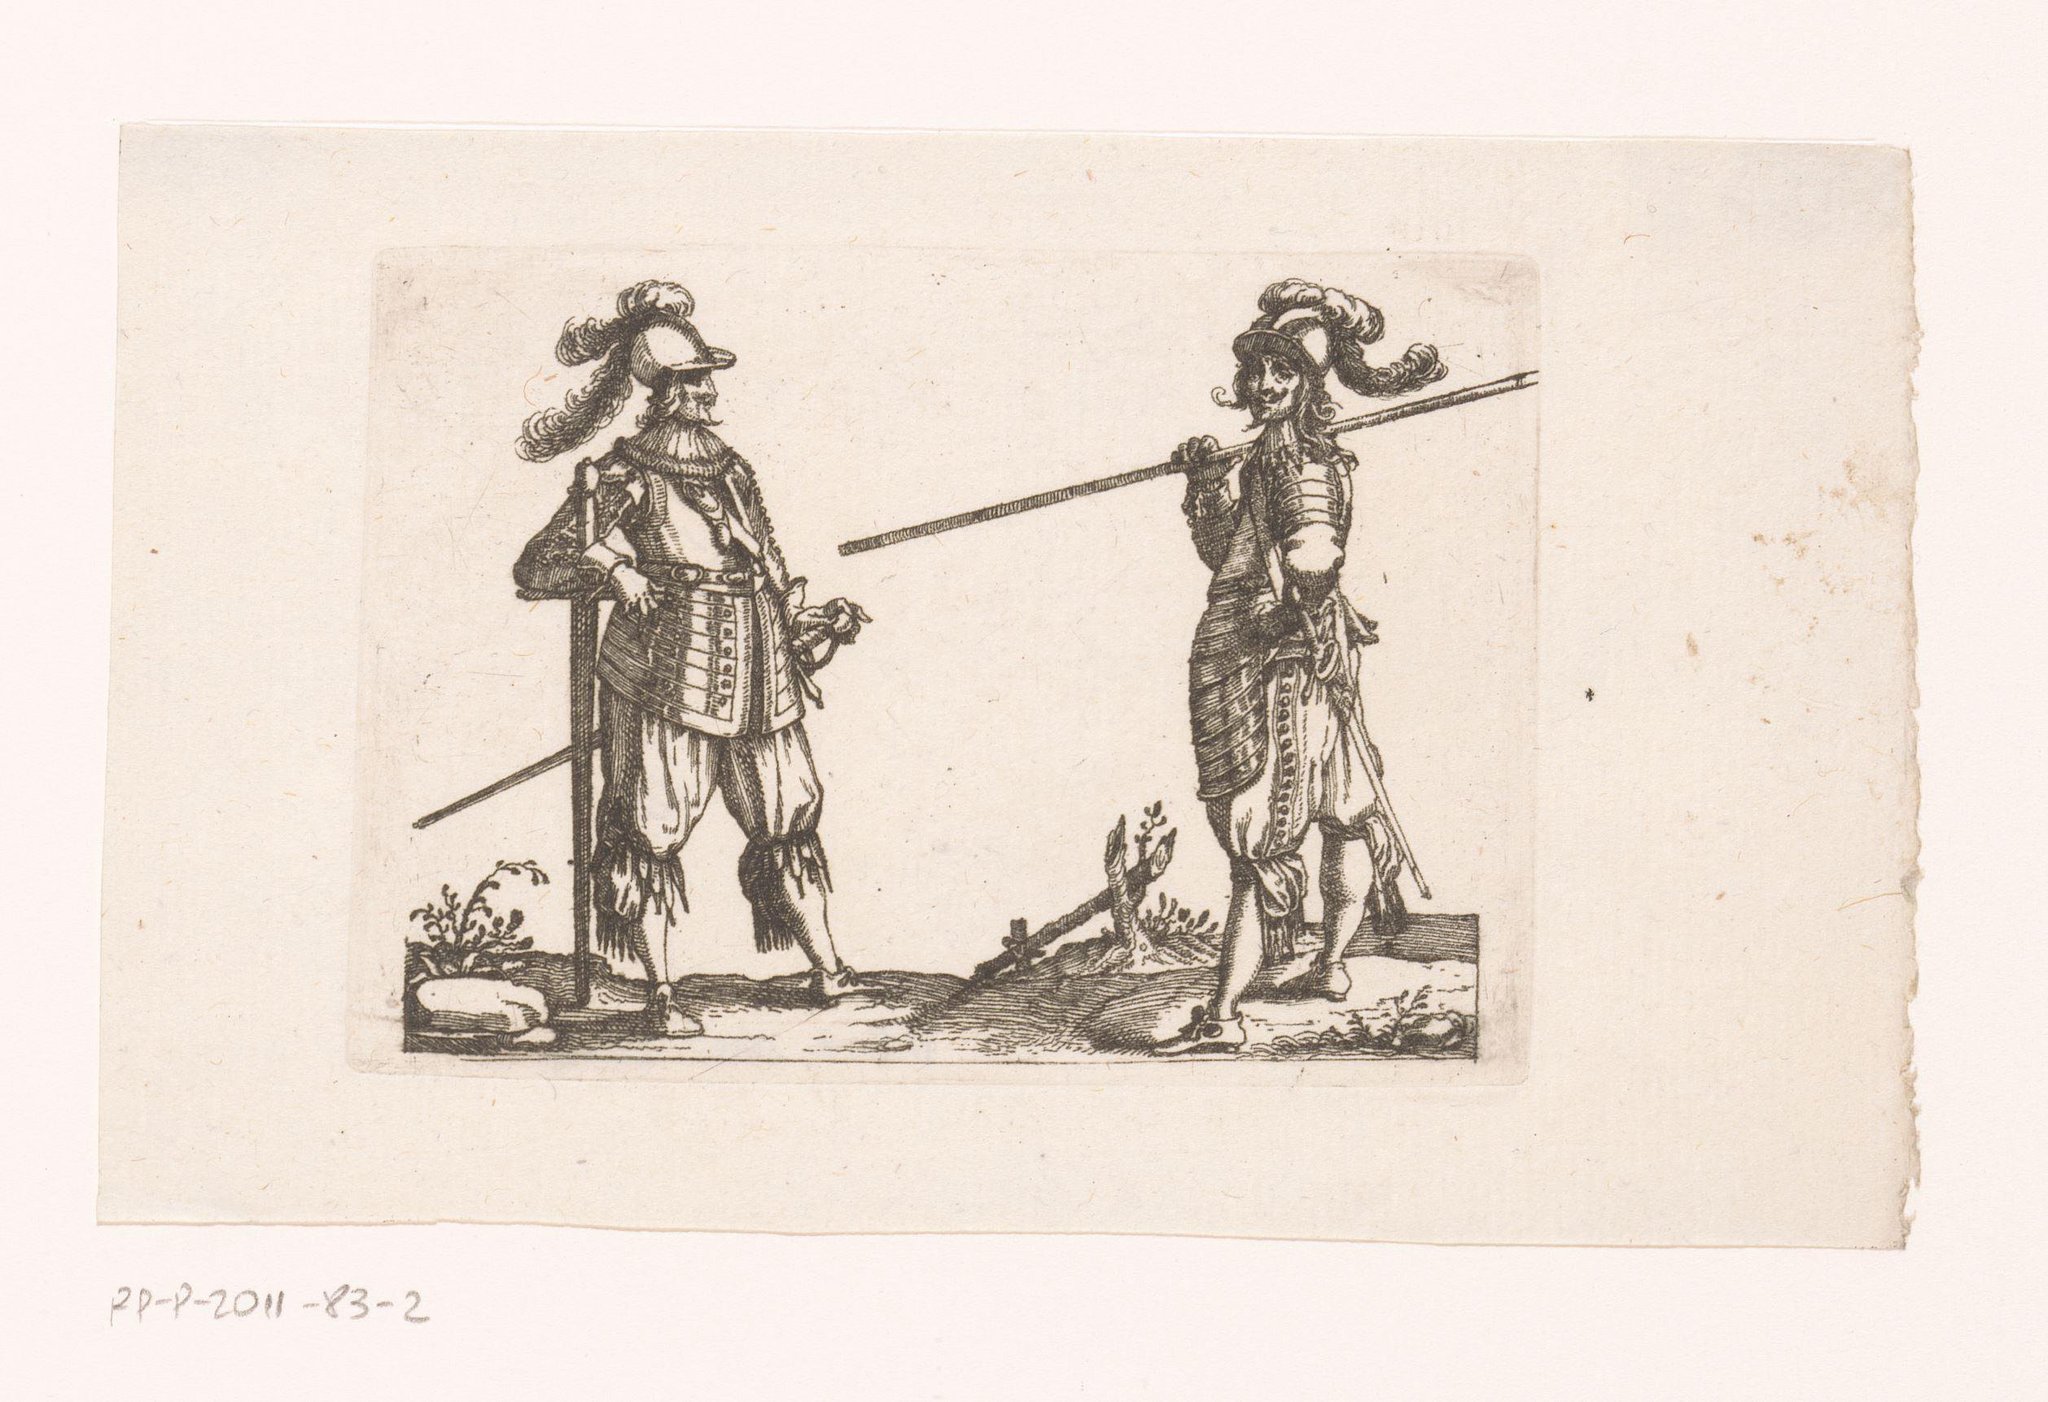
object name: print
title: Soldaten en edelmannen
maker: rudolph meyer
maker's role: print maker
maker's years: 1605-1638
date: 1615-1638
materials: paper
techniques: etching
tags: helved weapons, polearms (for striking, hacking, thrusting): pike, armour, hacking and thrusting weapons: sword, the soldier; the soldier's life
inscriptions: collector's mark: Lugt 2228, collector's mark: Lugt 2233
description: Onderdeel van een serie van zestien voorstellingen van soldaten (Soldatenbüchli).